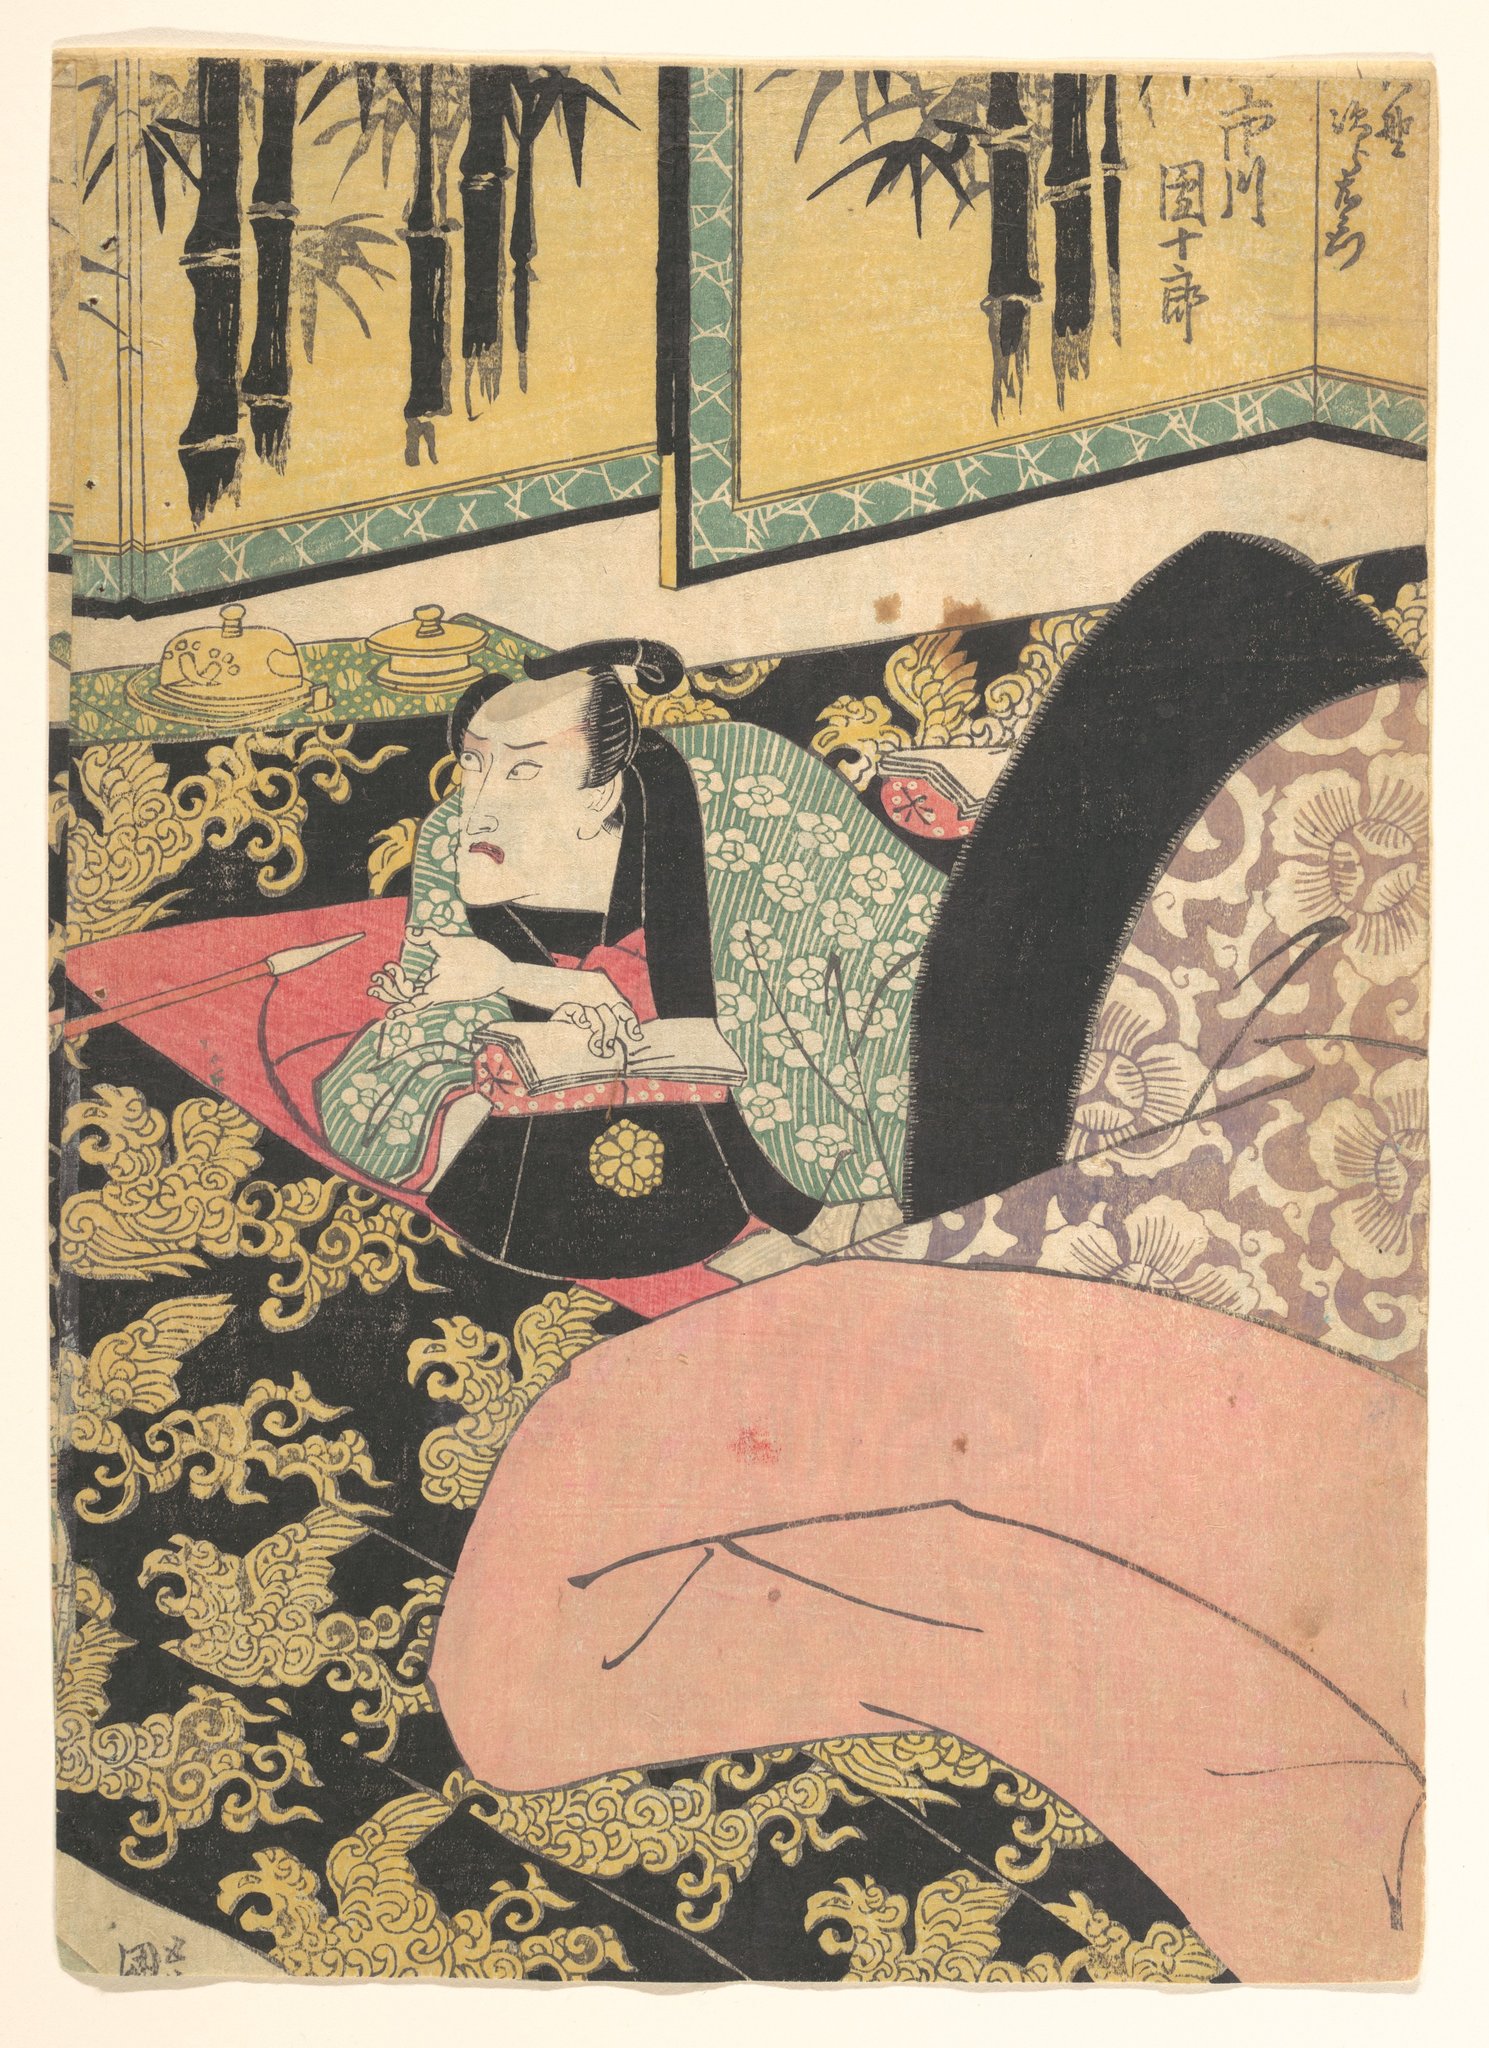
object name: print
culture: japanese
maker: utagawa kunisada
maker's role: artist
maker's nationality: japanese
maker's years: 1786-1864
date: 1801-1900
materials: ink, paper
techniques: woodblock print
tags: men,bamboo